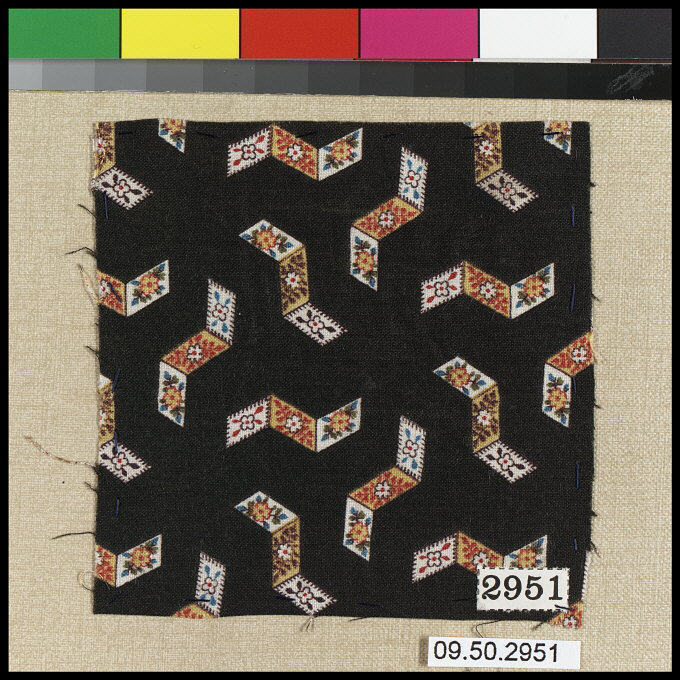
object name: piece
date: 1801-1900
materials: cotton